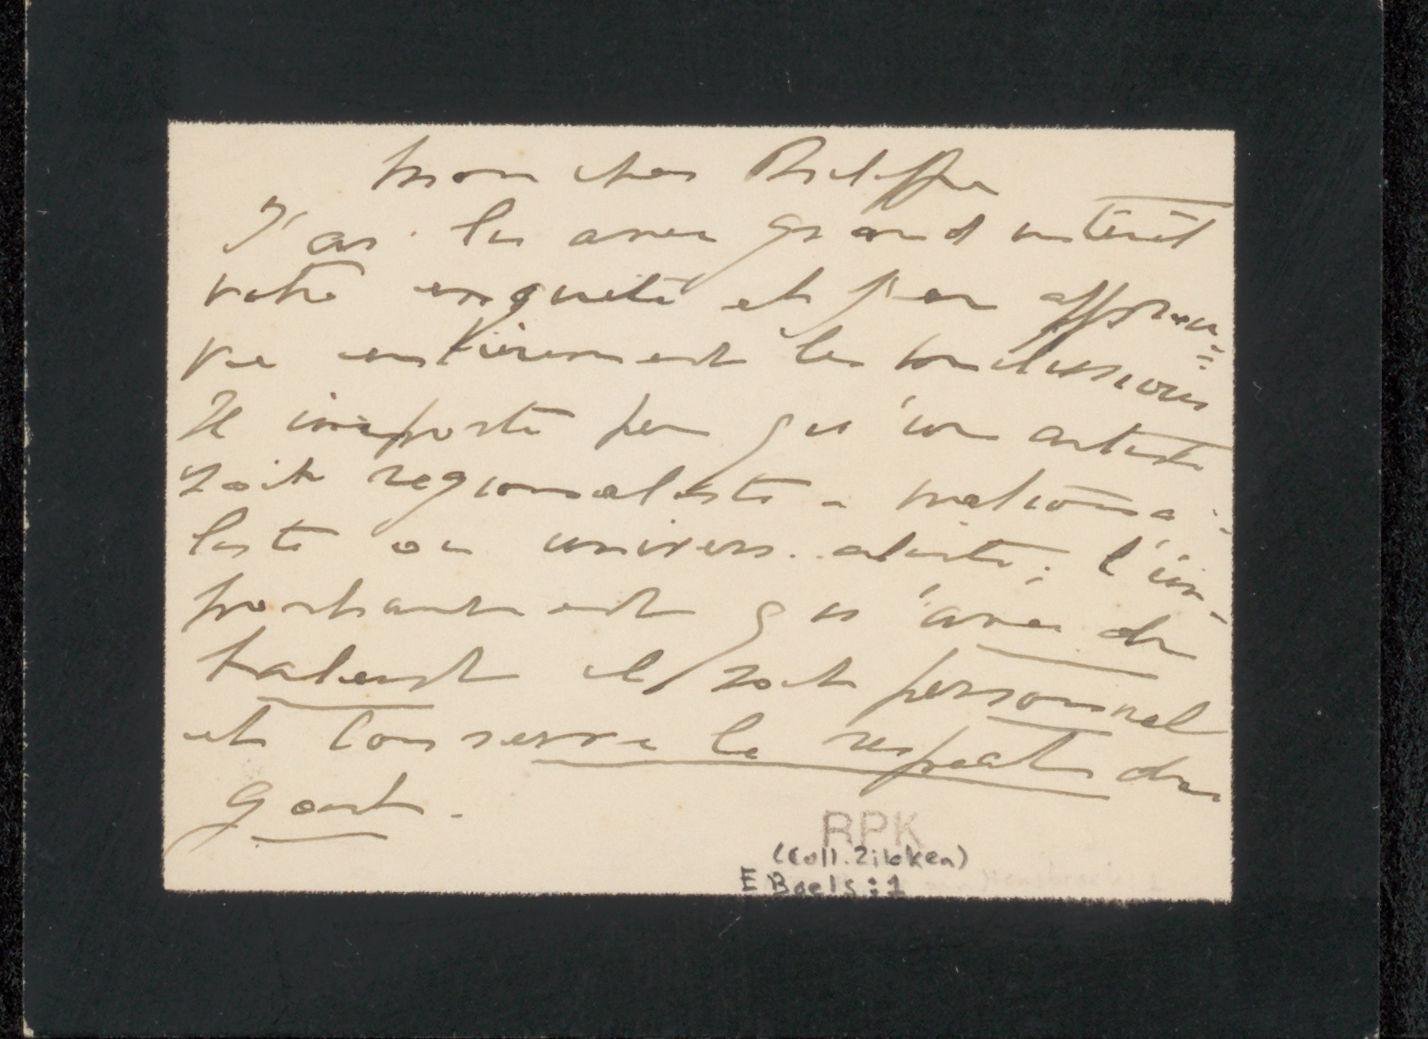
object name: letter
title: Brief aan Philip Zilcken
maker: emile boels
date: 1913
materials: cardboard, ink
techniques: pen, writing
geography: elsene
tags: the hague, painter, philip zilcken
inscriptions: collector's mark: ‘RPK’